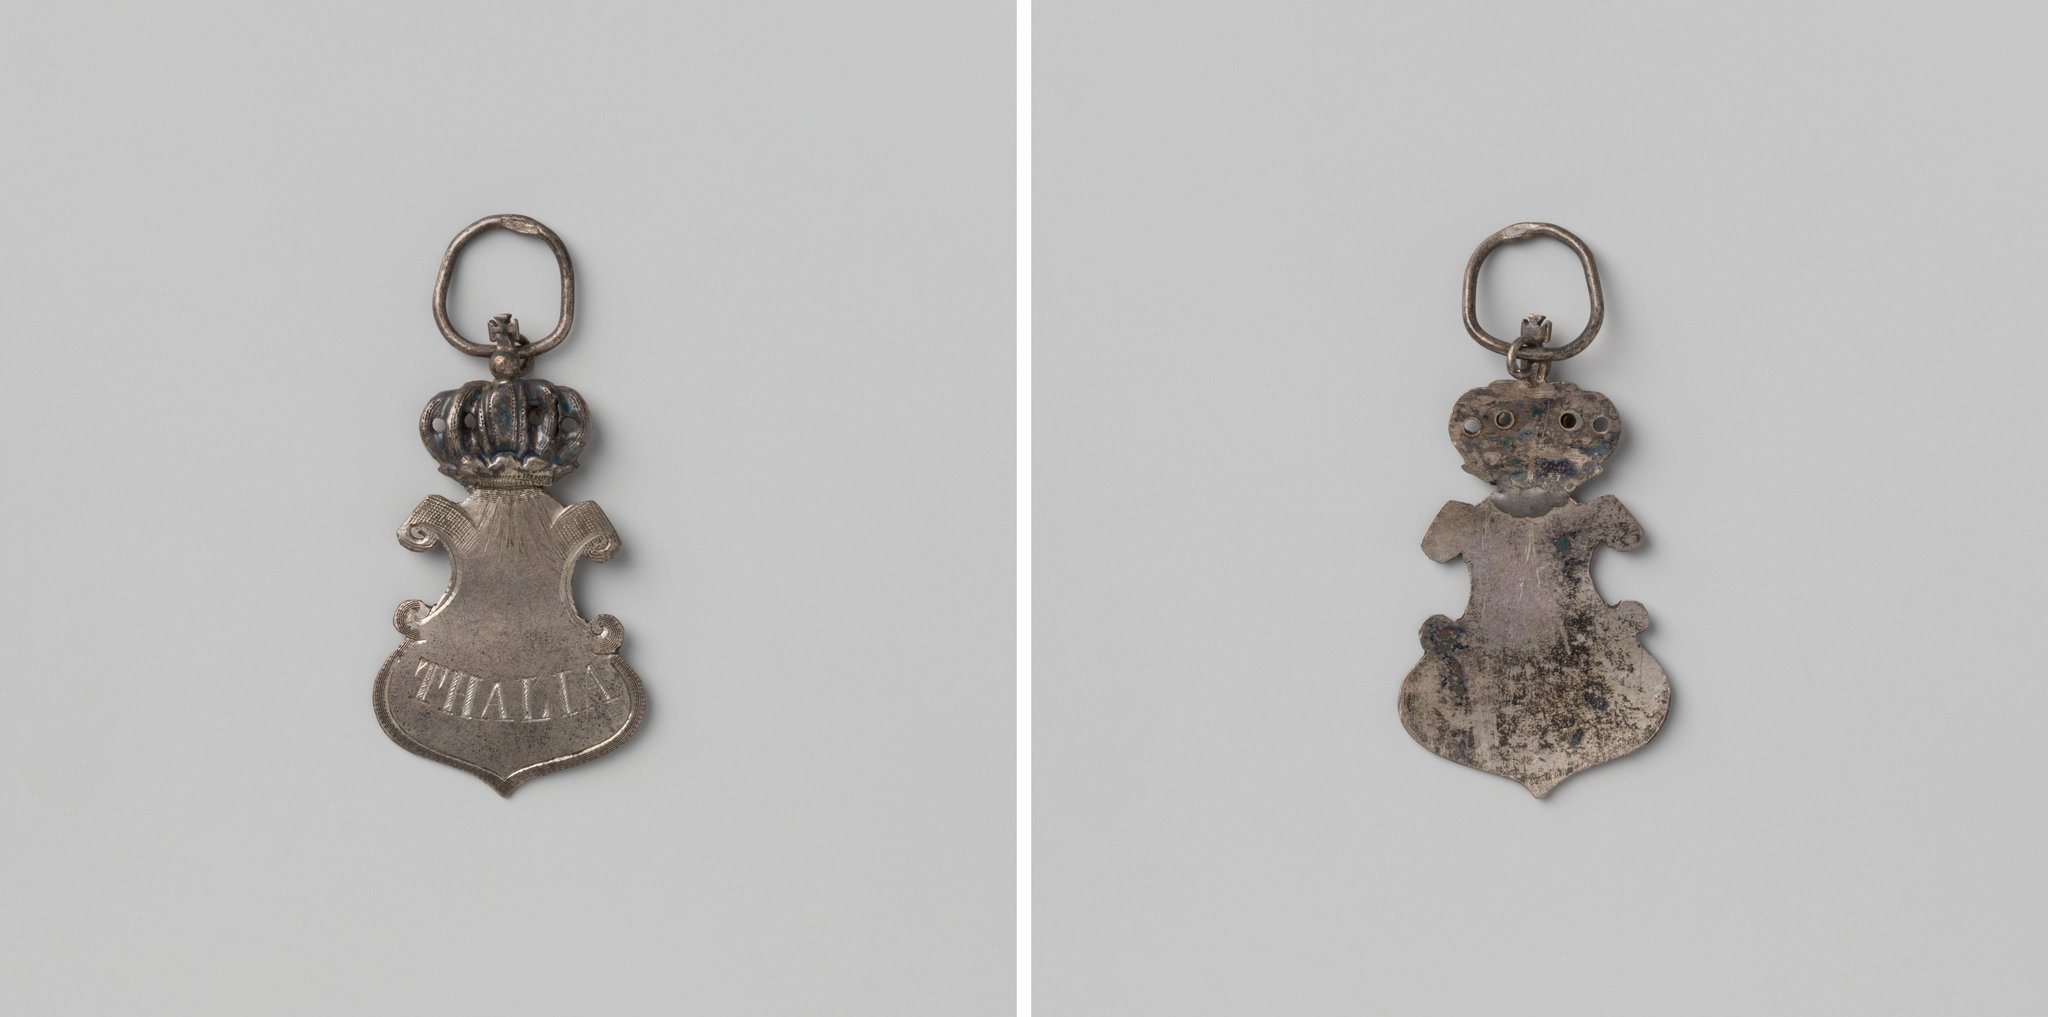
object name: insignia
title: Toneelgenootschap 'Thalia' te Dordrecht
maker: Anonymous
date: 1825-1875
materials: silver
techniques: engraving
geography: dordrecht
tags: dordrecht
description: Eenzijdig zilveren draagteken in vorm van gekroond schild aan draagoog en draagring; op schild: opschrift.